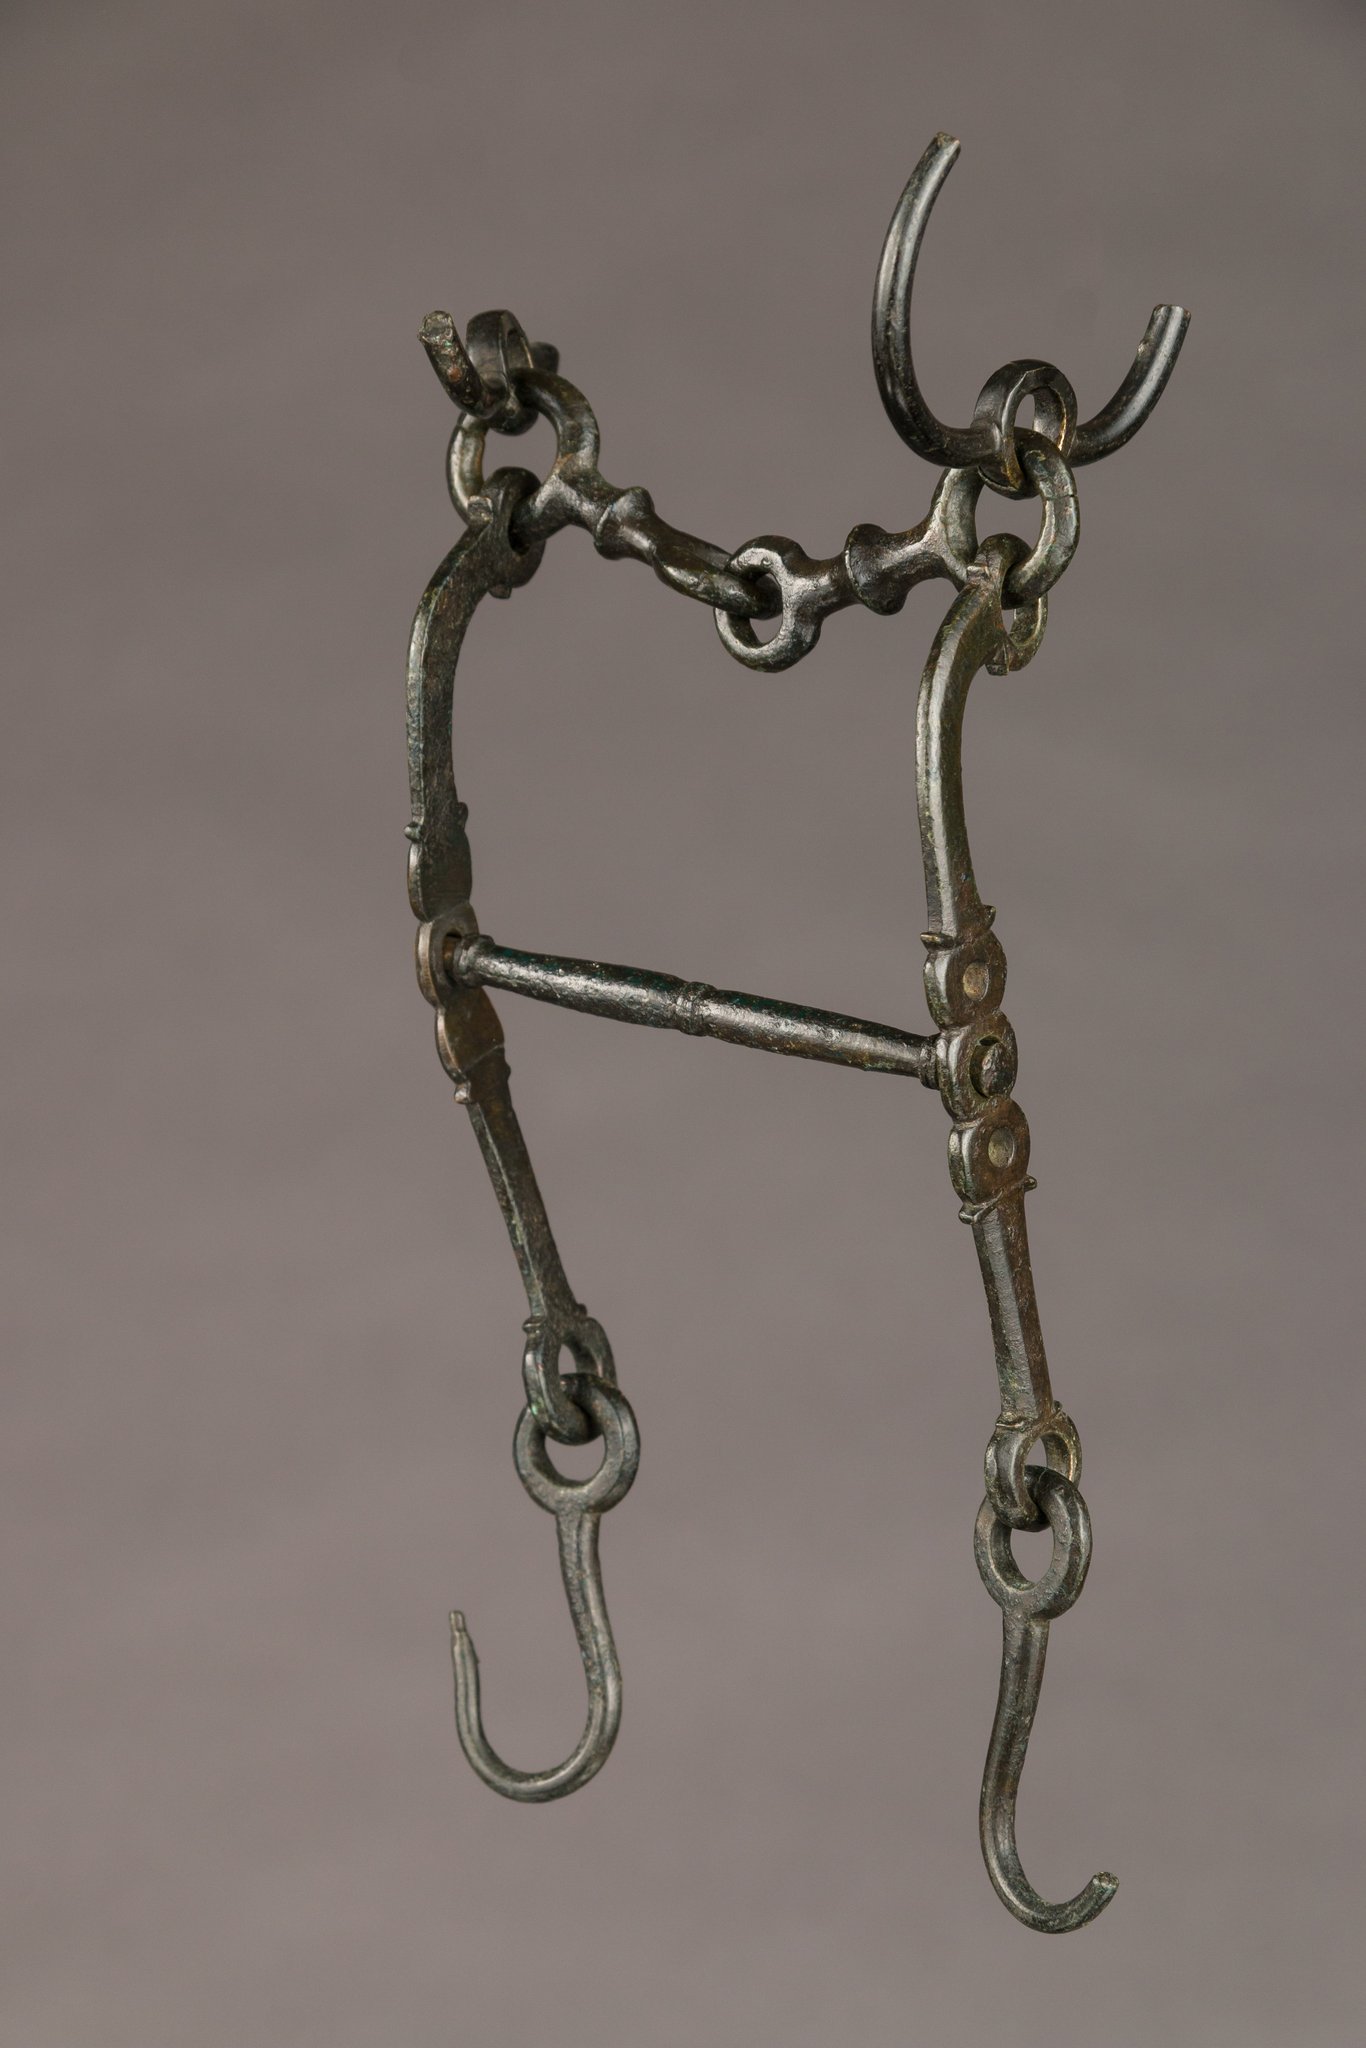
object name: bit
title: Curb Bit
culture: thracian or celtic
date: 200-1 BCE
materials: copper alloy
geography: bulgaria